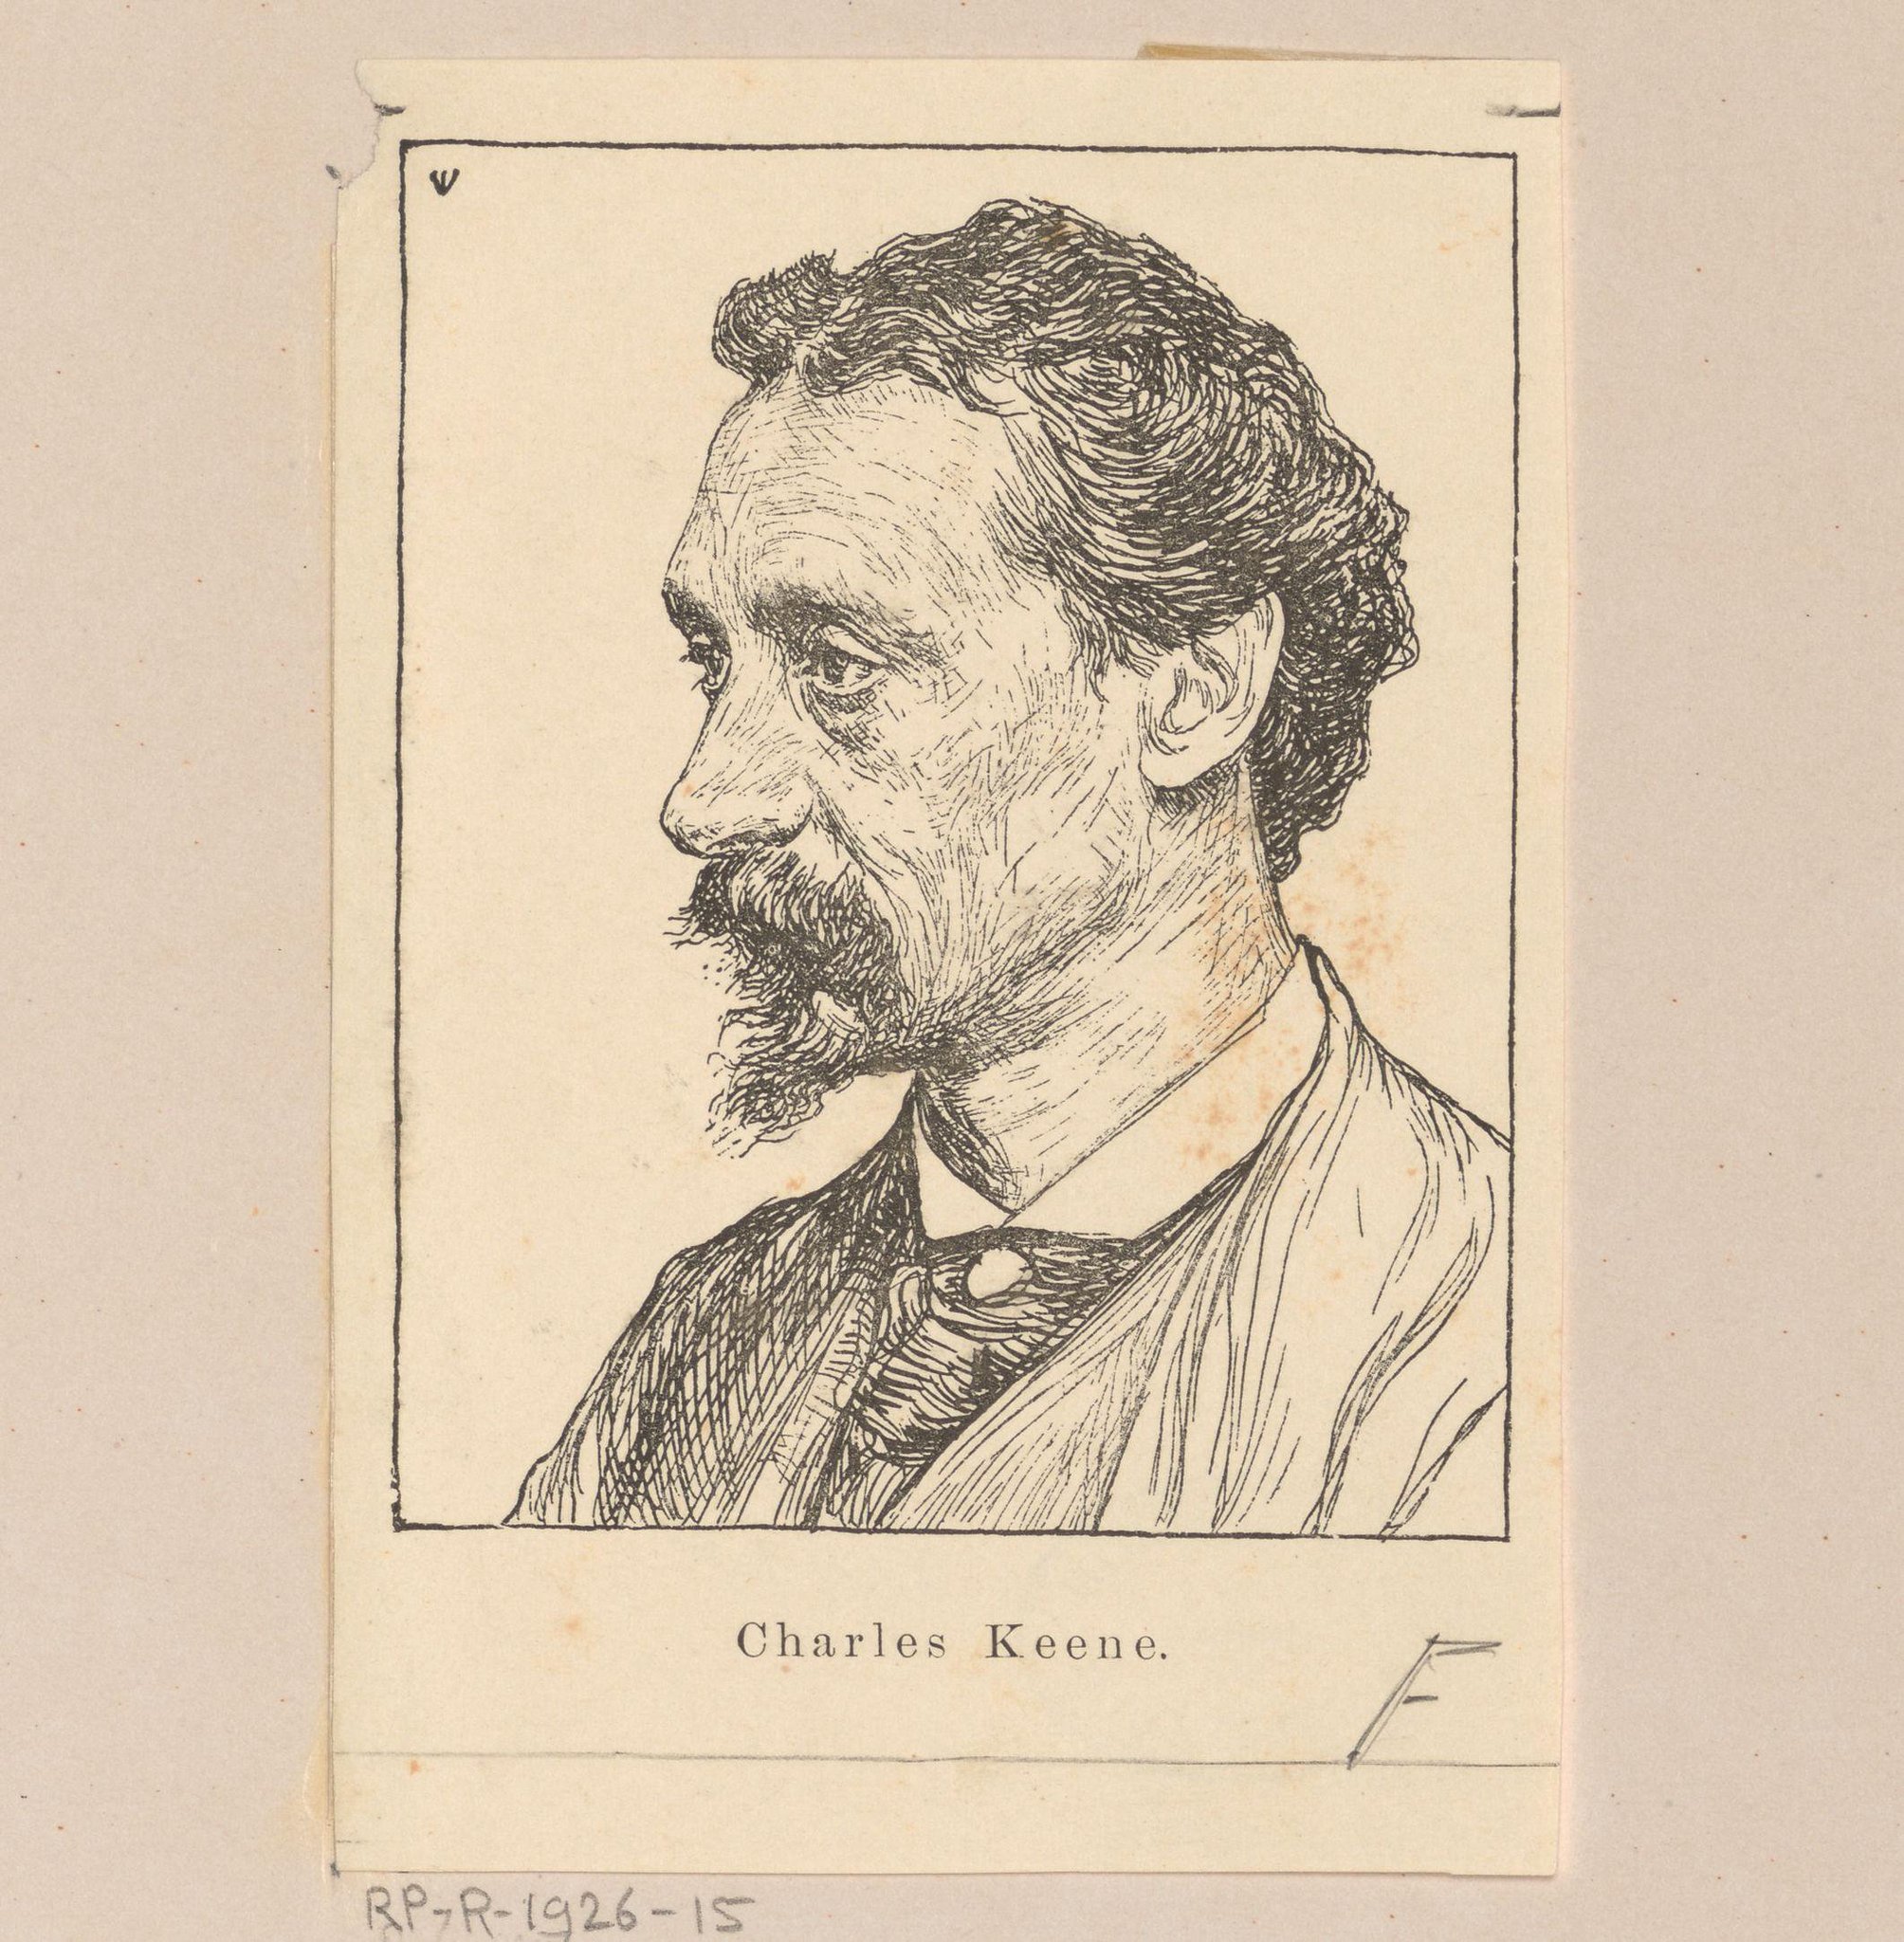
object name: photomechanical print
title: Portret van Charles Keene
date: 1895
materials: paper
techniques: printing block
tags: london, historical persons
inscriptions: stamp: ‘H.G. Samson Amsterdam’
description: Prent mogelijk uit: Pijzel, E.D. Mannen en vrouwen van beteekenis (...). Haarlem: Hermanus Diedericus Tjeenk Willink, 1895.